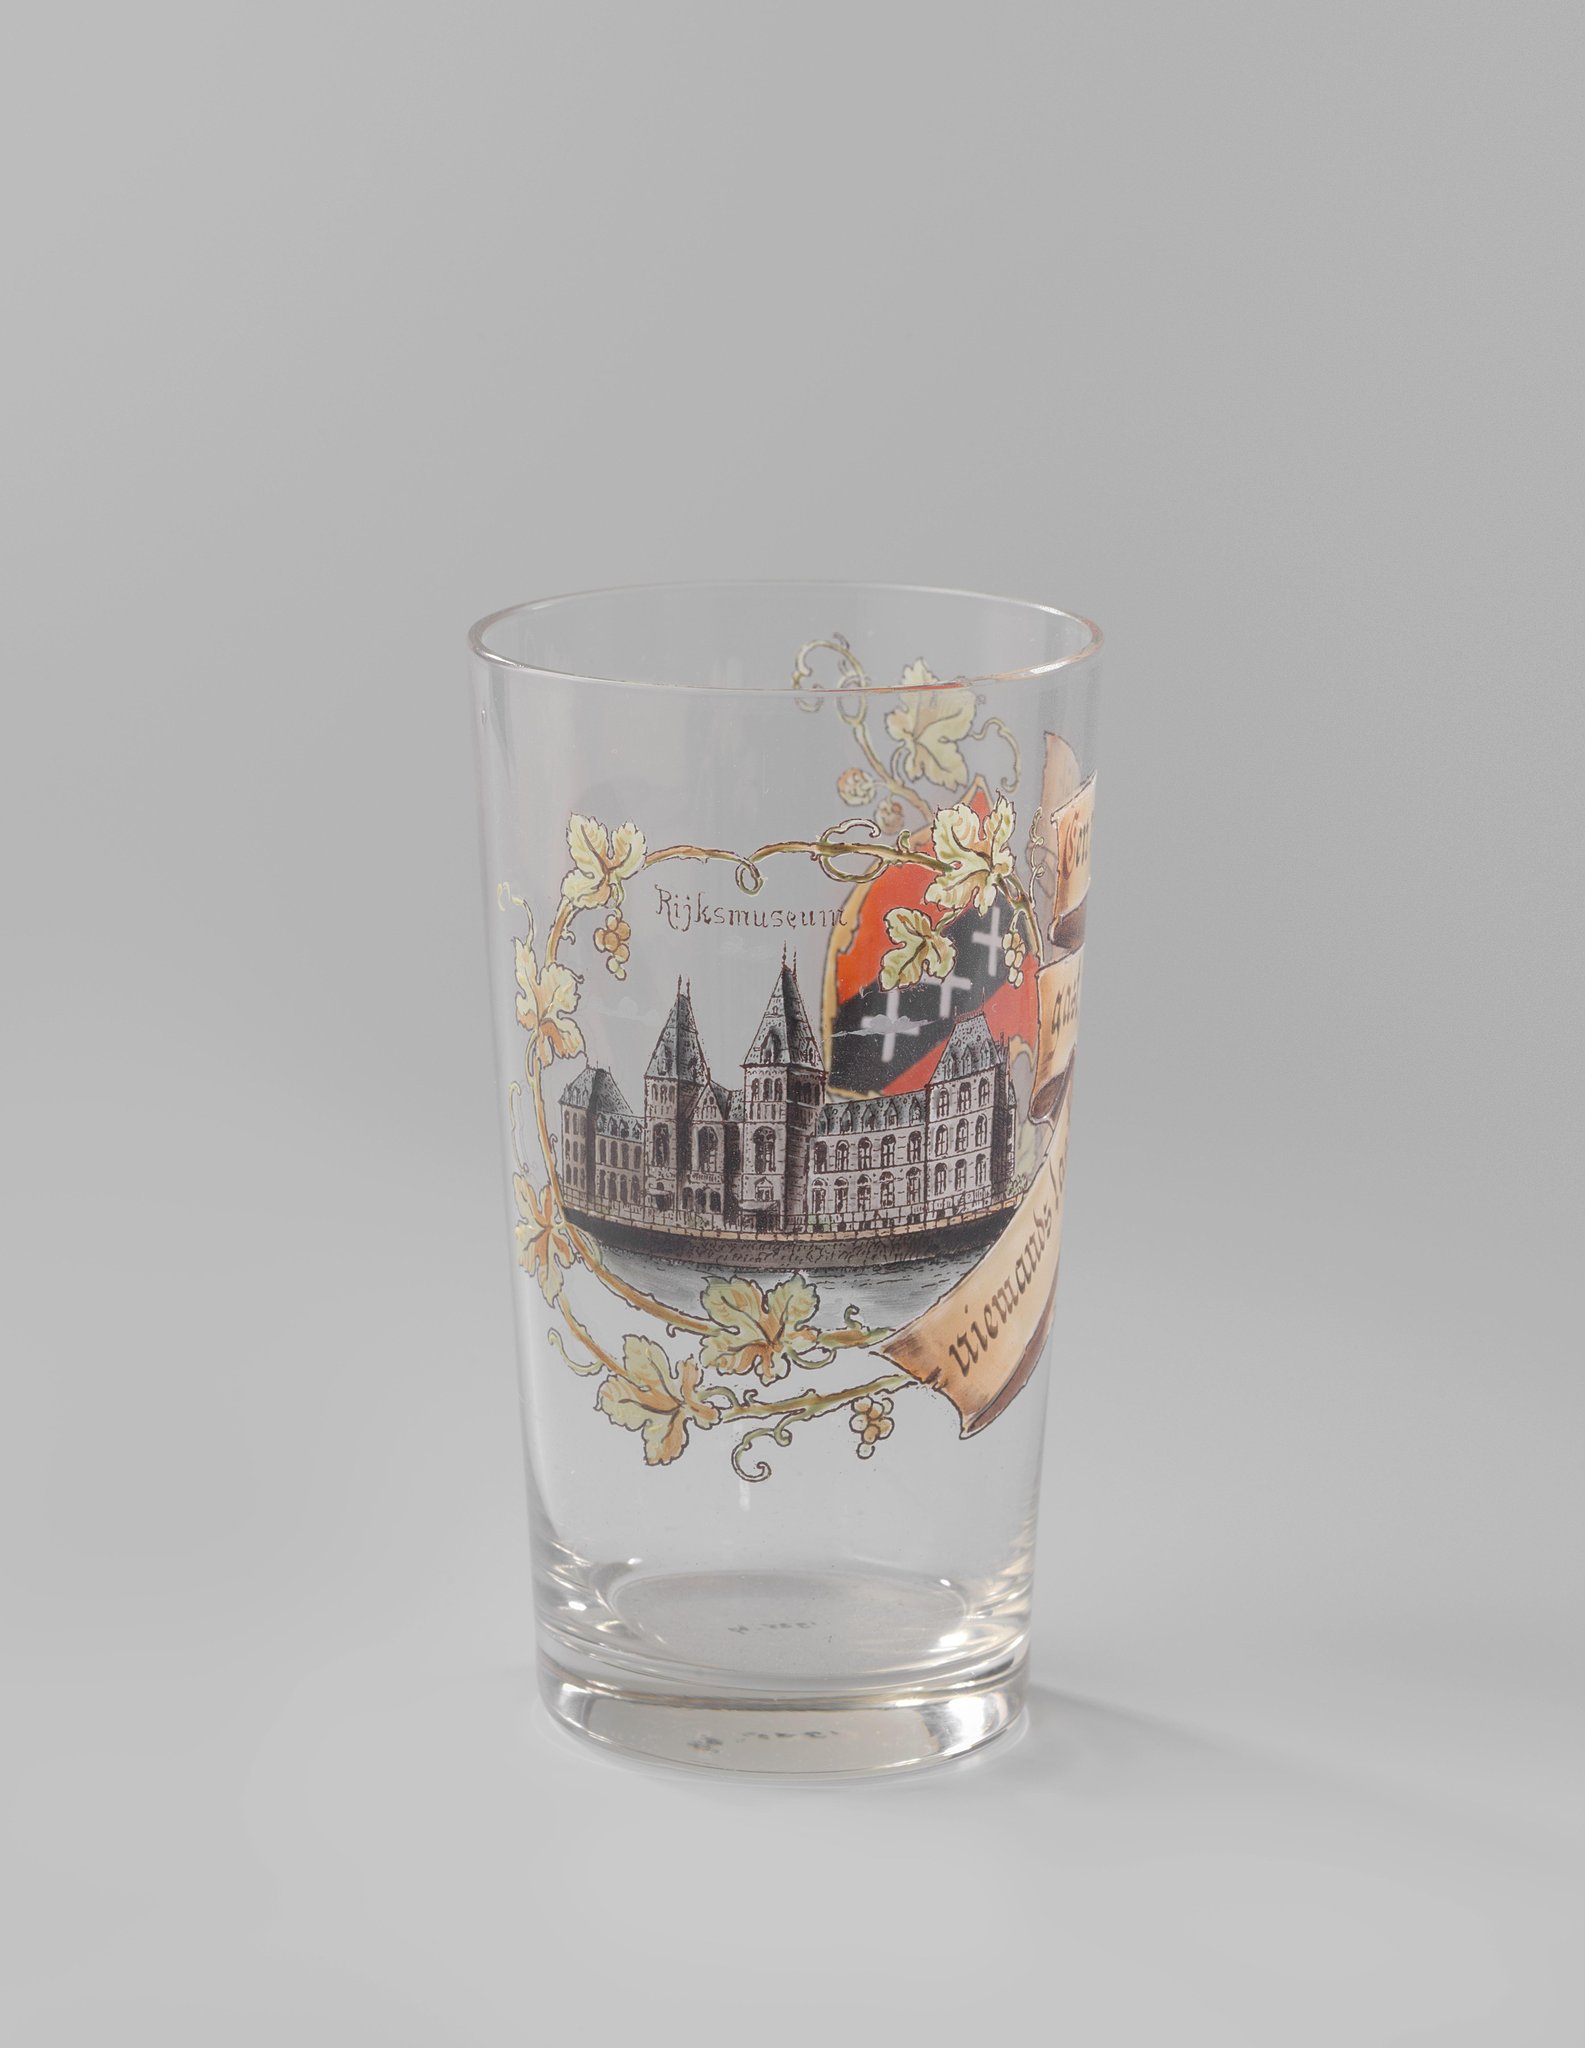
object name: cup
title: Beker van helder kleurloos glas, beschilderd in polychroom email met het Rijksmuseum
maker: Anonymous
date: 1885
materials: glass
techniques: enamel painting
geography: netherlands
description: Beker van helder kleurloos glas, beschilderd in polychroom email met het Rijksmuseum en een banderolle met 'EEN VROOLIJK GAST, IS NIEMANDS LAST'. Nederland, ca. 1885.